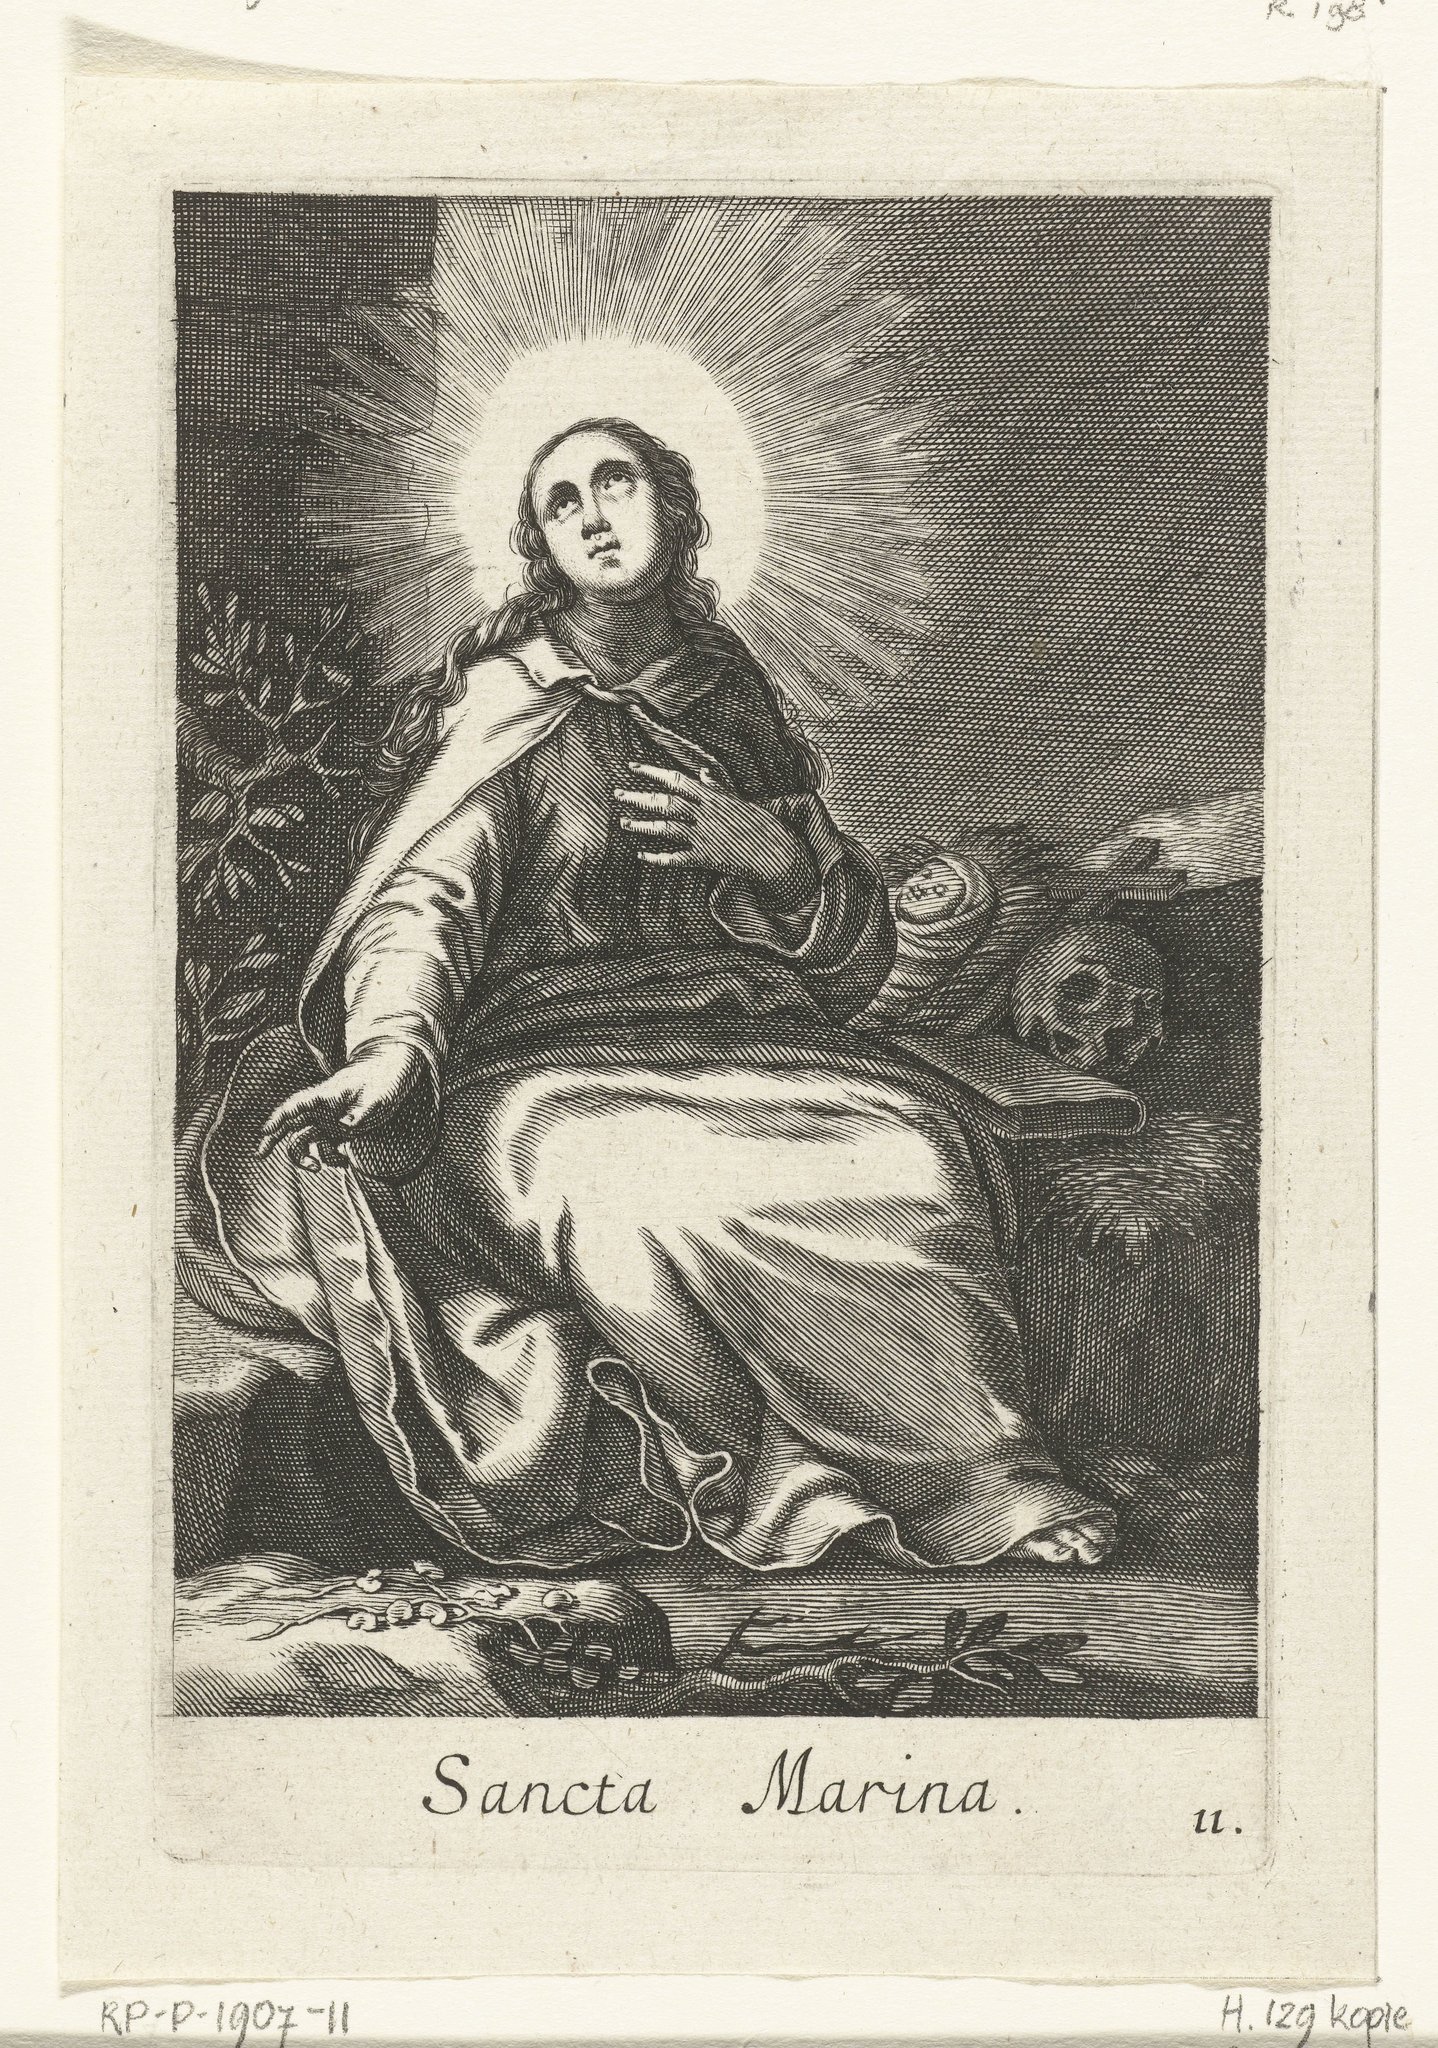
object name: print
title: Heilige Marina van Alexandrië als kluizenares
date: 1590-1662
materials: paper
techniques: engraving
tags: anchorite, hermit, female saints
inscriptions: collector's mark: Lugt 2228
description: Kopie in spiegelbeeld naar prent van Boëtius Adamsz. Bolswert uit serie Kluizenaressen.